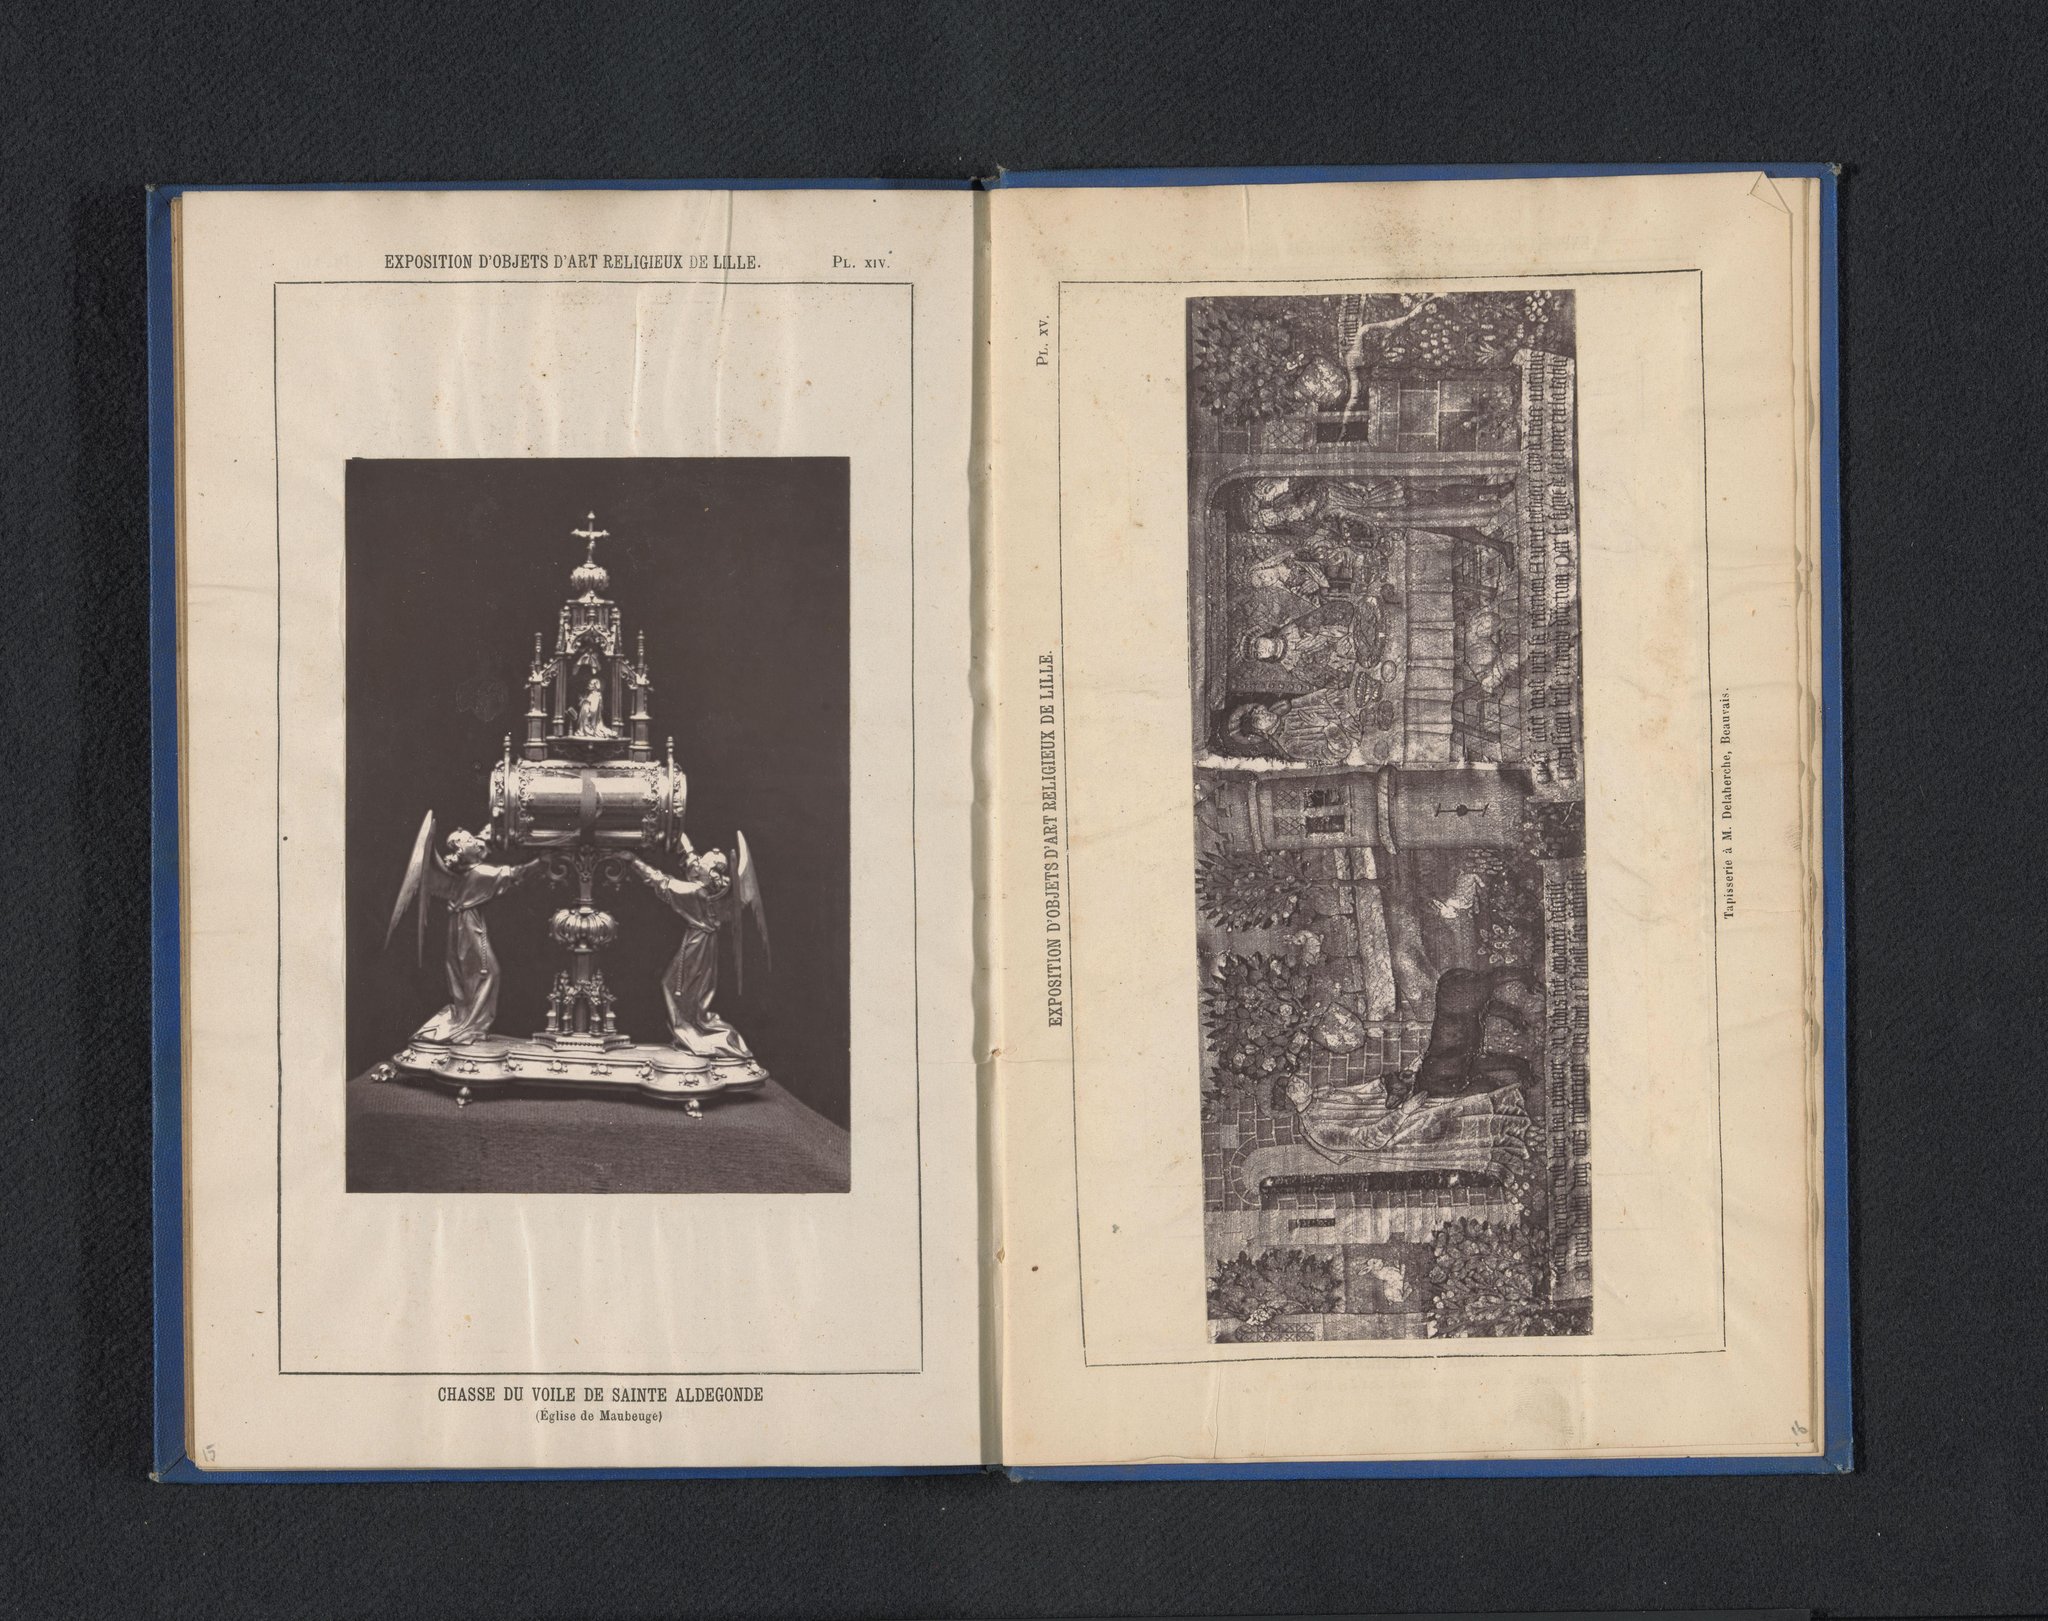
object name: photomechanical print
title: Monstrans van Sint Aldegonde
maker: Anonymous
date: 1871-1876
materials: cardboard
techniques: woodburytype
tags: ostensorium, monstrance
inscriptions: inscription: ‘Pl. XIV.’, inscription: ‘Exposition d'objets d'art religieux de Lille’, inscription: ‘Église de Maubeuge’